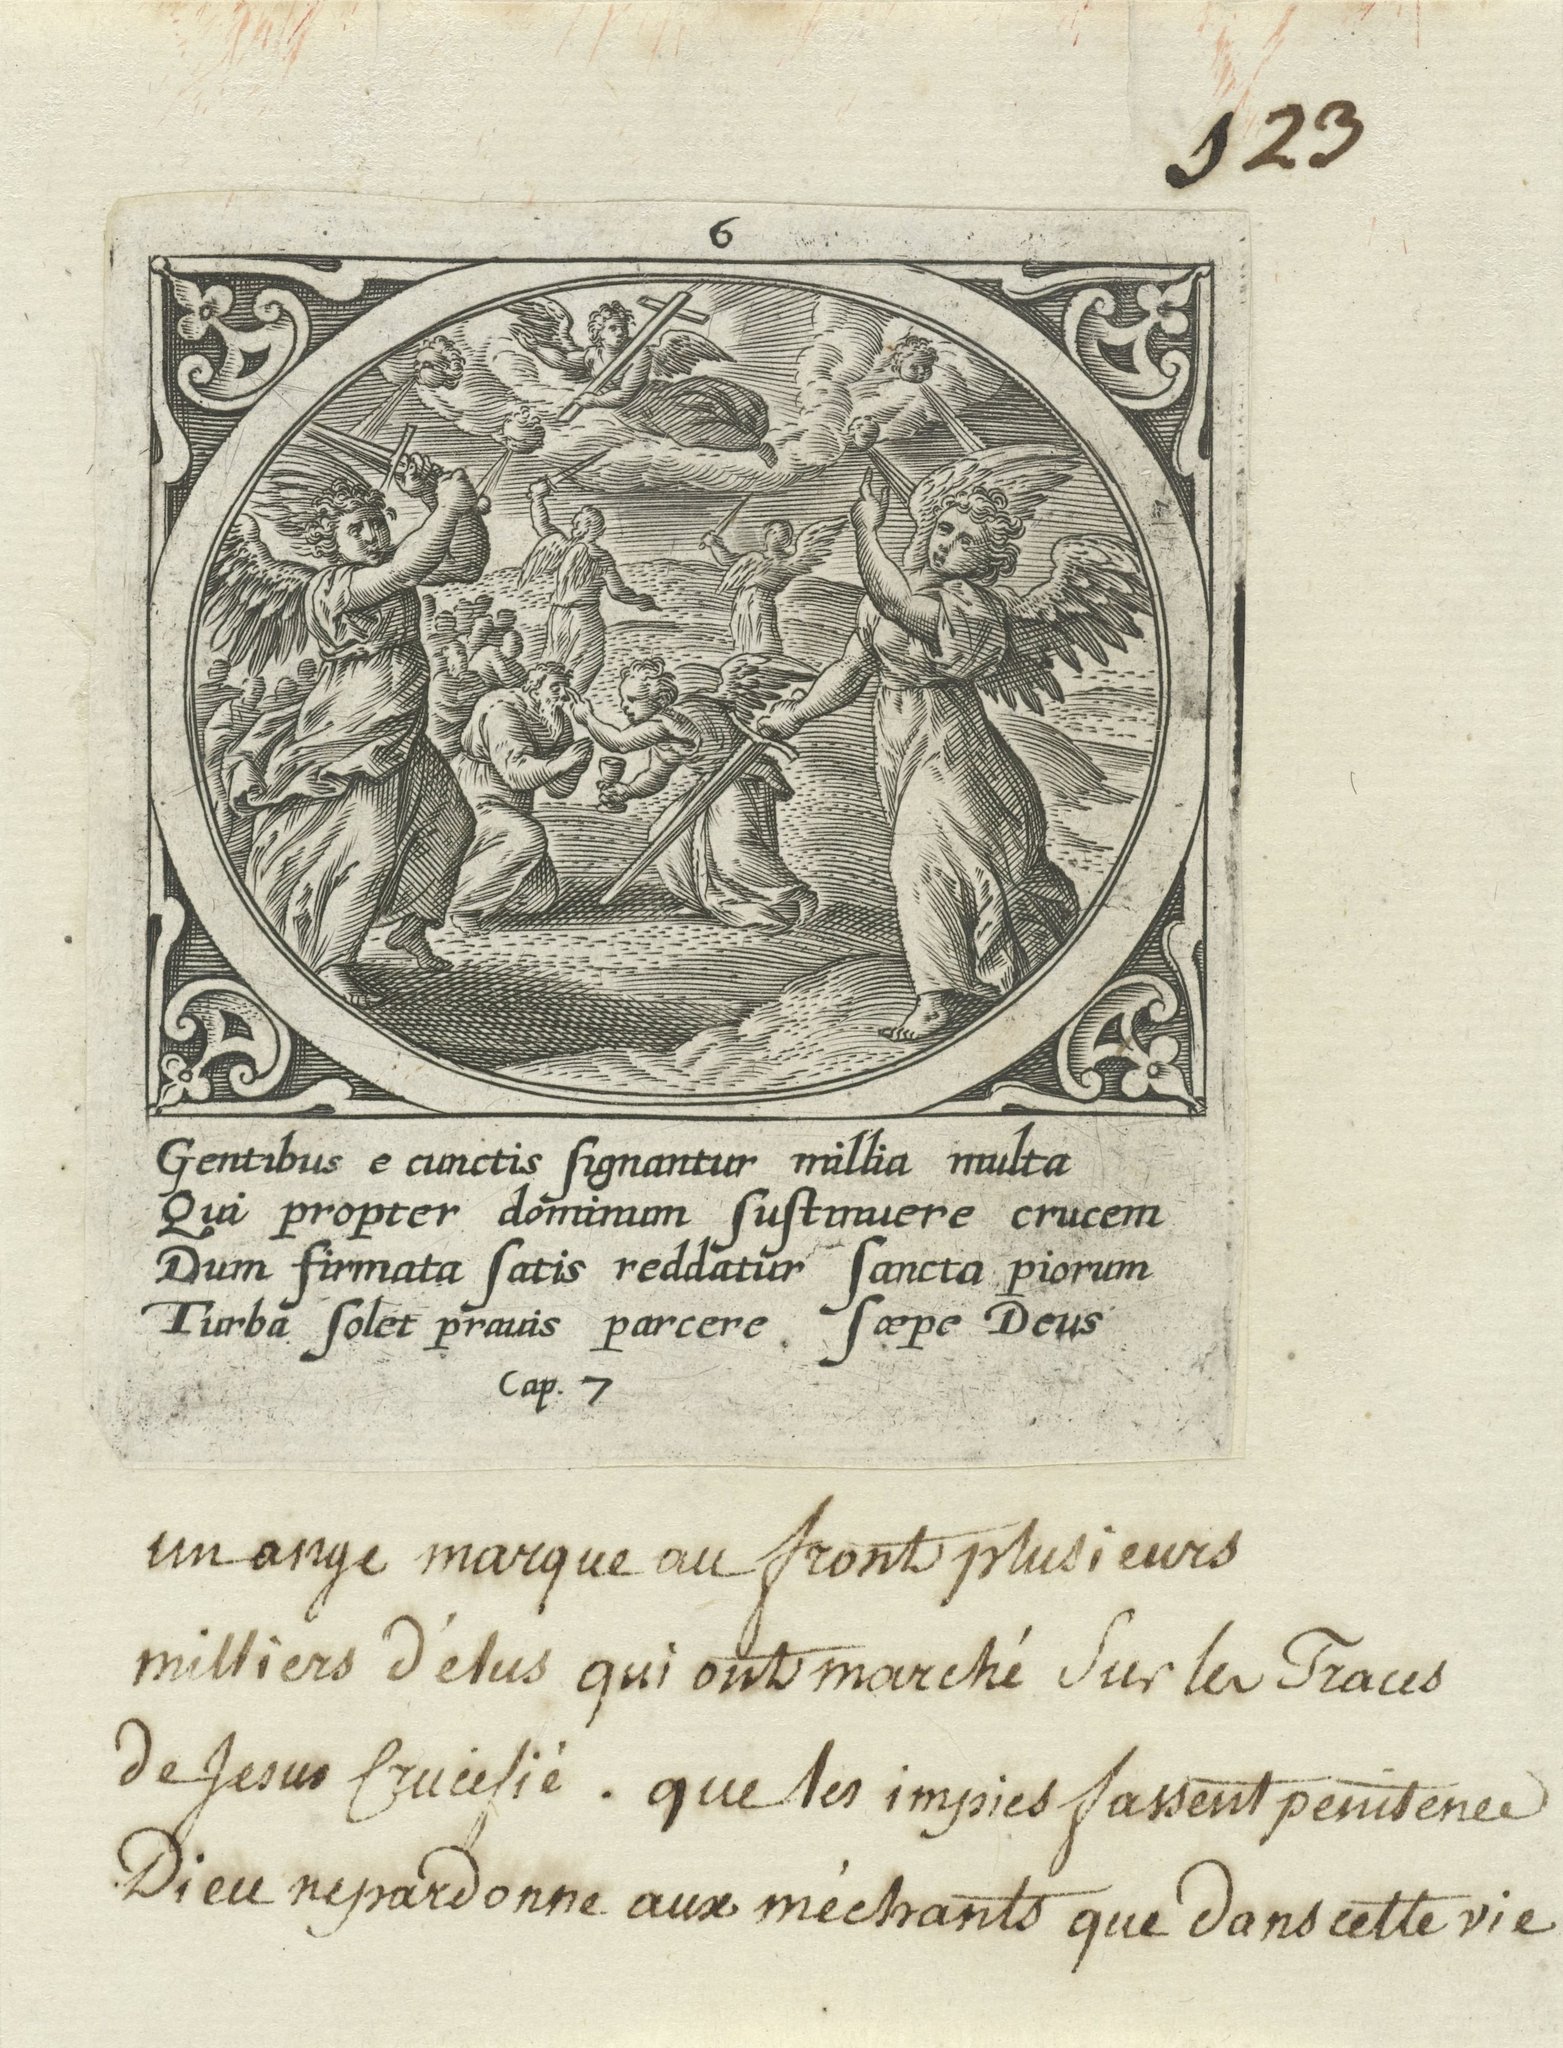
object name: print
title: Icones Revelationum S Johs Evangeliste in Pathmo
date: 1585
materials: paper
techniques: engraving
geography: antwerp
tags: the four winds are restrained by four angels, sealing of the tribes of israel, the 144-thousand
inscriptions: inscription: ‘123’, inscription: ‘un ange marque [...] dans cette vie.’, collector's mark: Lugt 2228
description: Vier engelen houden met hun zwaard de vier winden in bedwang. In het midden brengt een engel het zegel van God aan op het voorhoofd van een lid van een stam van Israël. Boven in de wolken een engel met een kruis. In de marge een vierregelig onderschrift in het Latijn. Zesde prent uit een serie van vierentwintig met de openbaring van Johannes op Patmos.